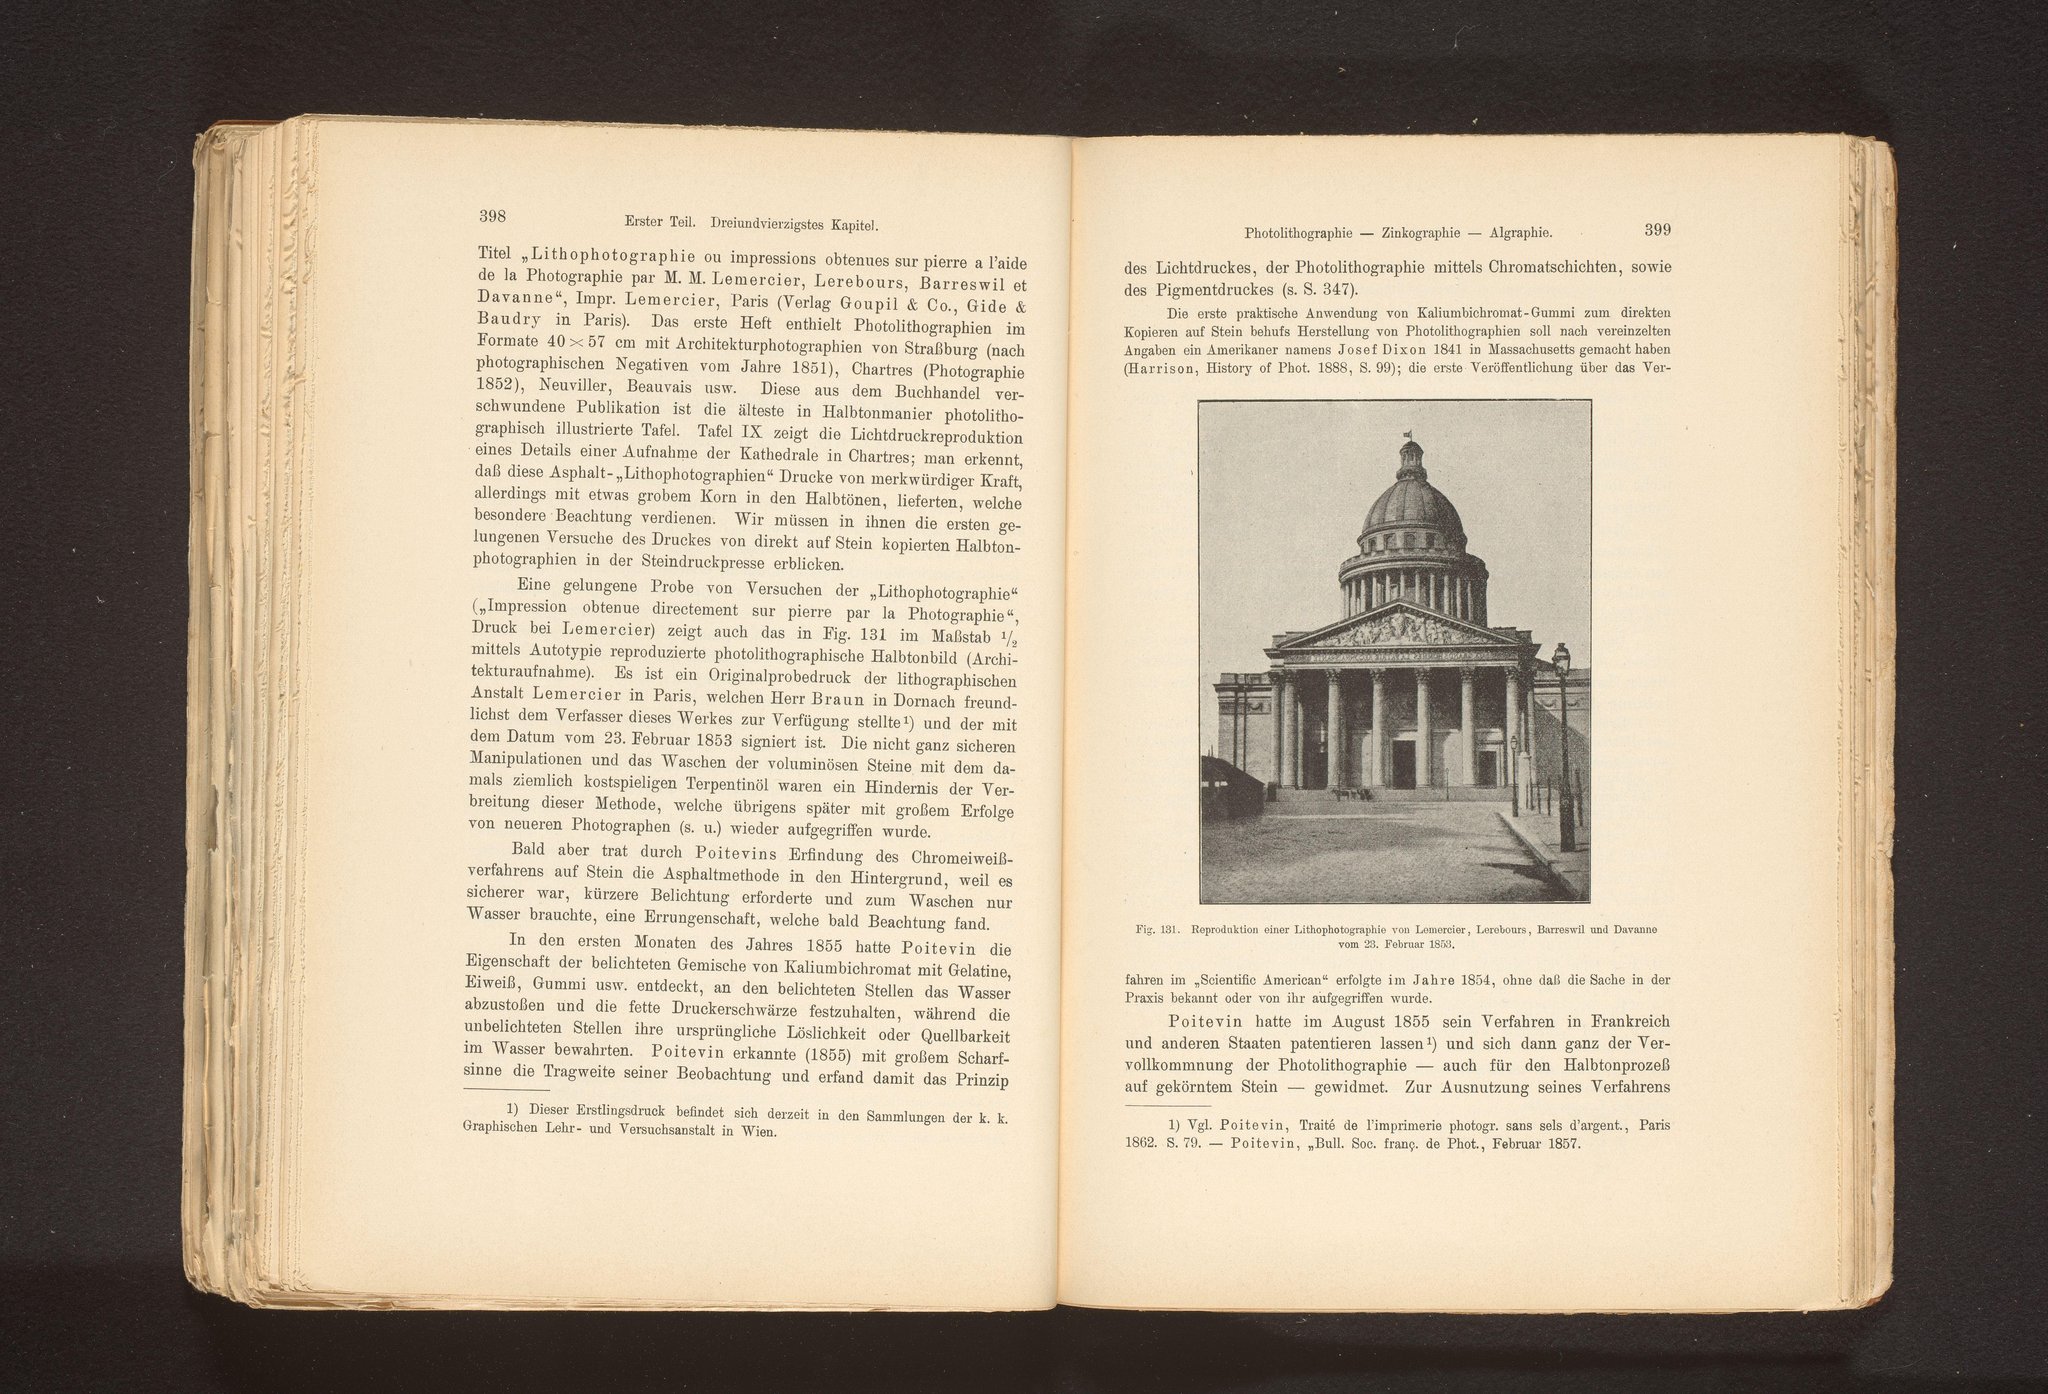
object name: page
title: Exterieur van het Panthéon te Parijs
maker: Anonymous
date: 1900-1905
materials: paper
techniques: autotype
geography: paris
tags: façade (of house or building), cult of the dead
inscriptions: number: ‘Fig. 131.’, inscription: ‘Reproduction einer (...) Februar 1853.’